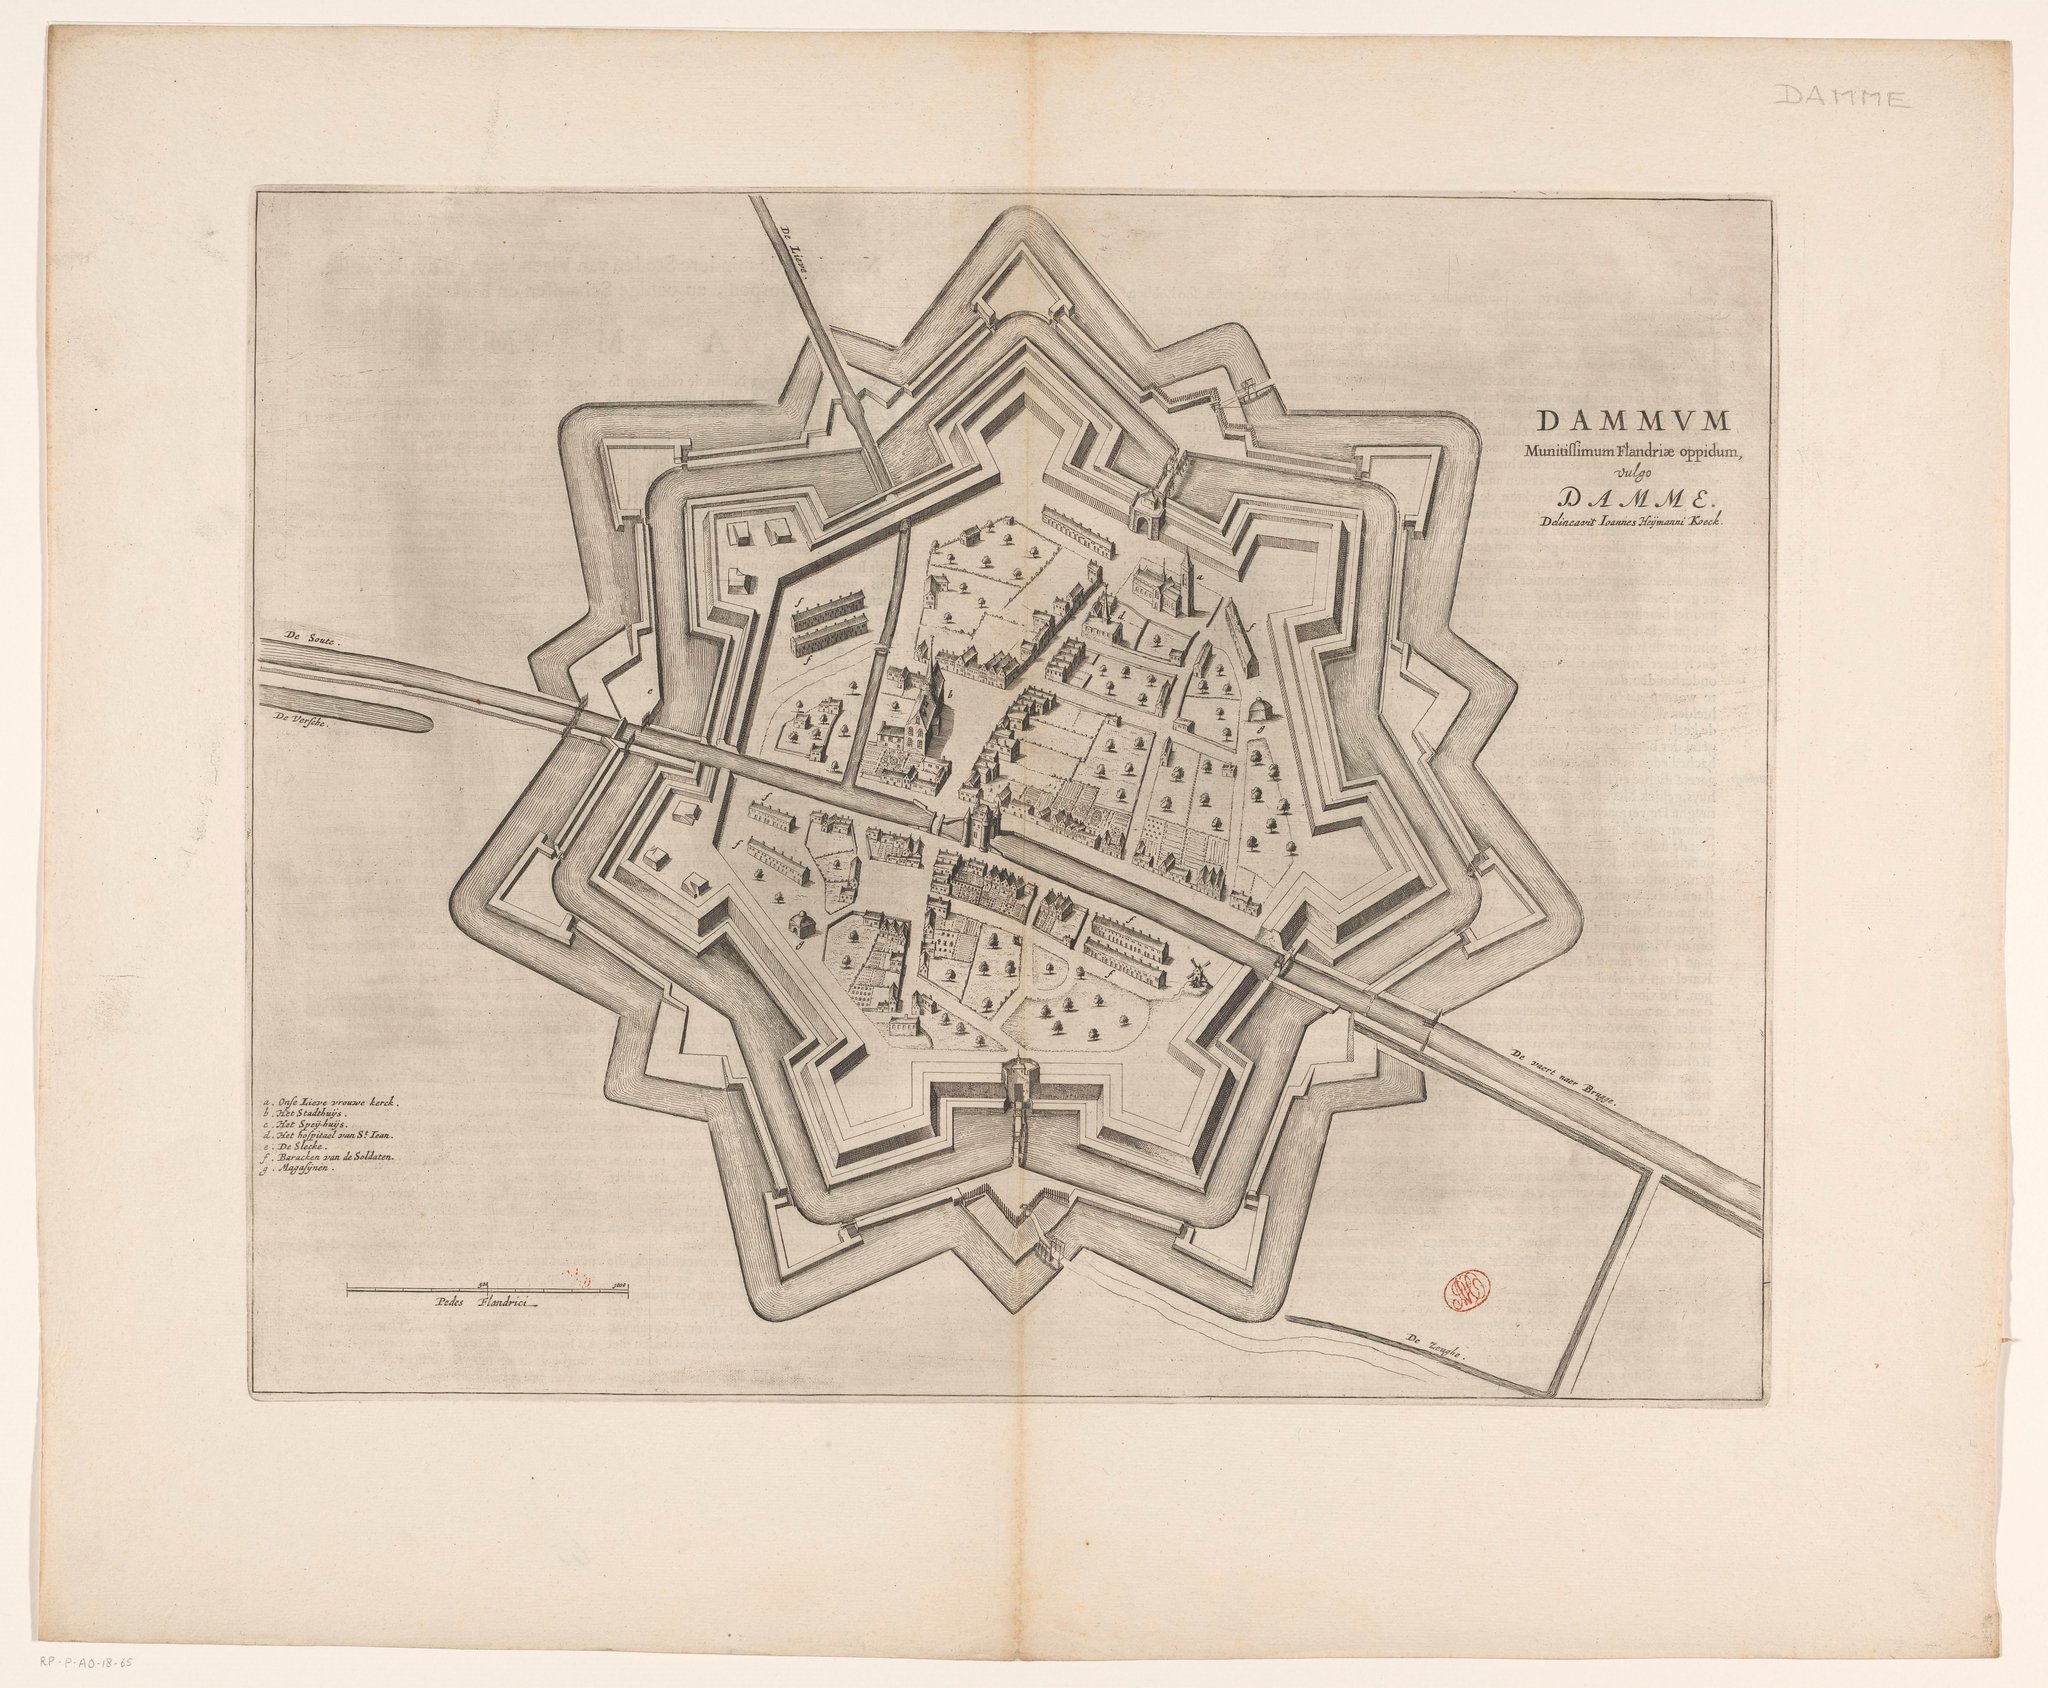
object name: area plan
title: Plattegrond van Damme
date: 1652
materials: paper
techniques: engraving, etching, letterpress printing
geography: amsterdam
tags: fortified city, maps of cities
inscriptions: collector's mark: Lugt 195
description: Plattegrond van Damme met gebouwen in vogelvluchtperspectief. Rechtsboven de titel. Linksonder een legenda a-g en daaronder een schaalstok: 1000 Pedes Flandrici. Met Nederlandse tekst op verso.